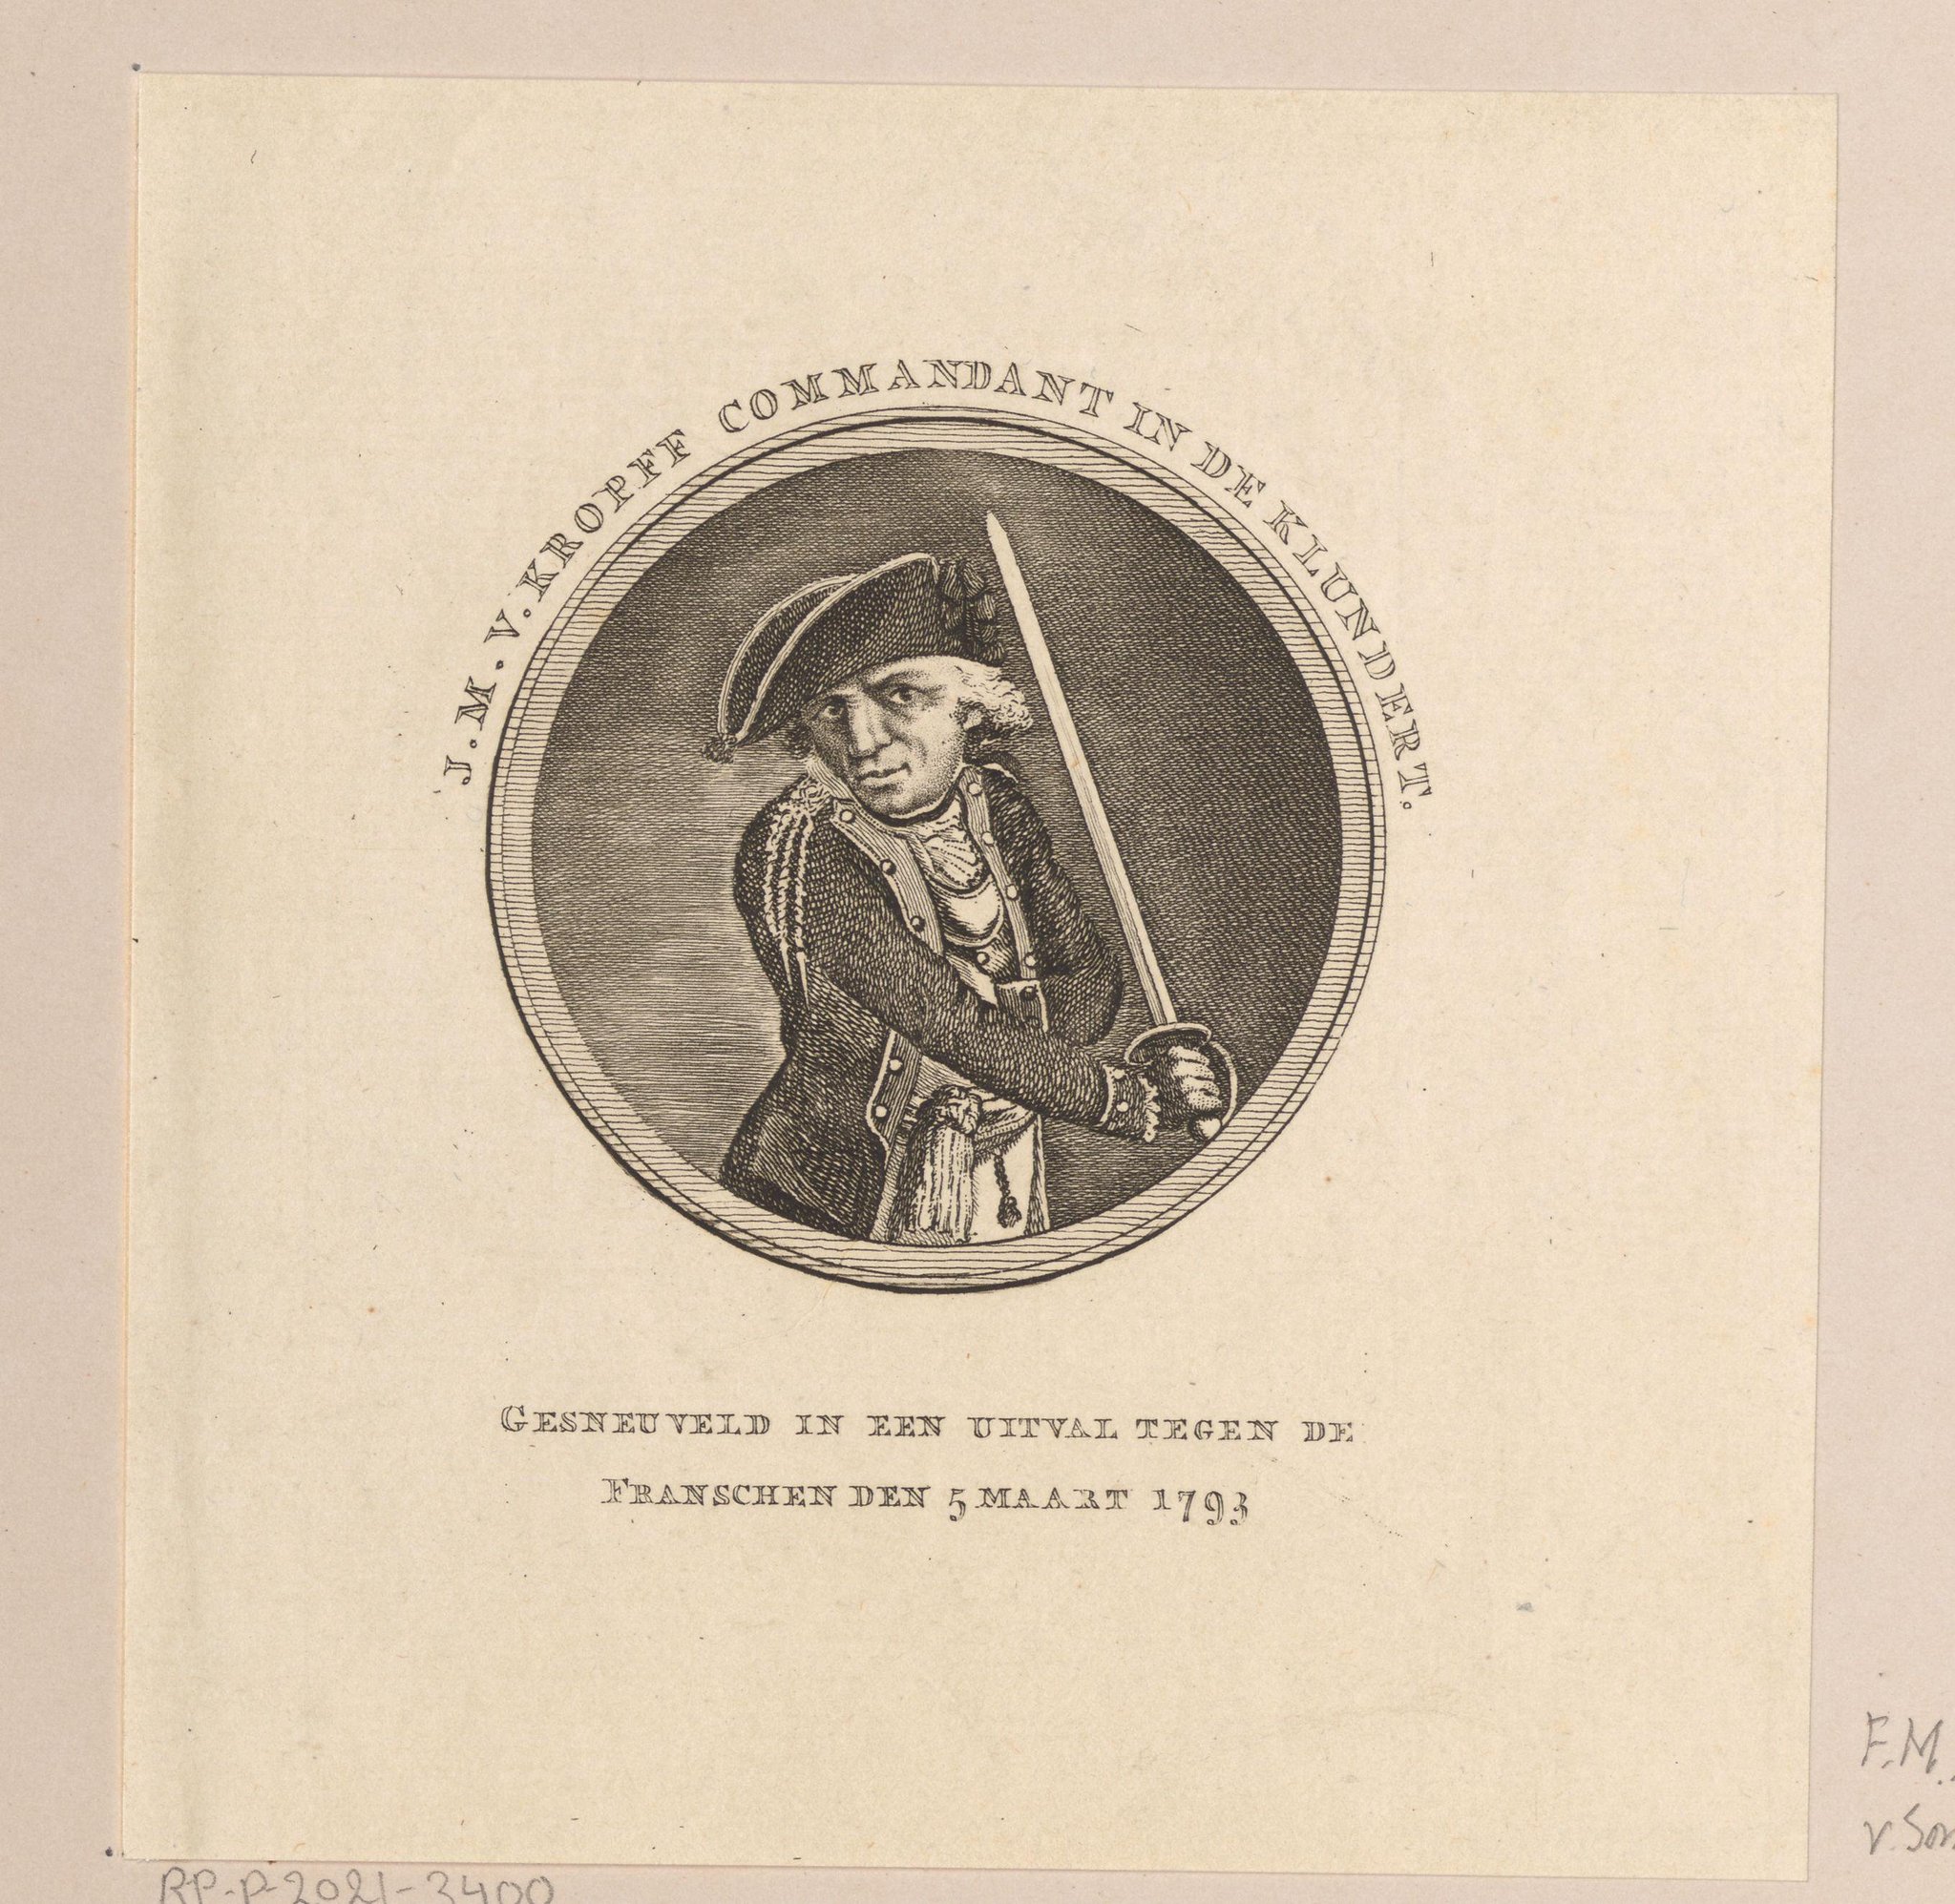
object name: print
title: Portret van Joachim Maurits baron van Kropff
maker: Anonymous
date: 1793-1849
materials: paper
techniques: etching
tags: klundert, historical persons